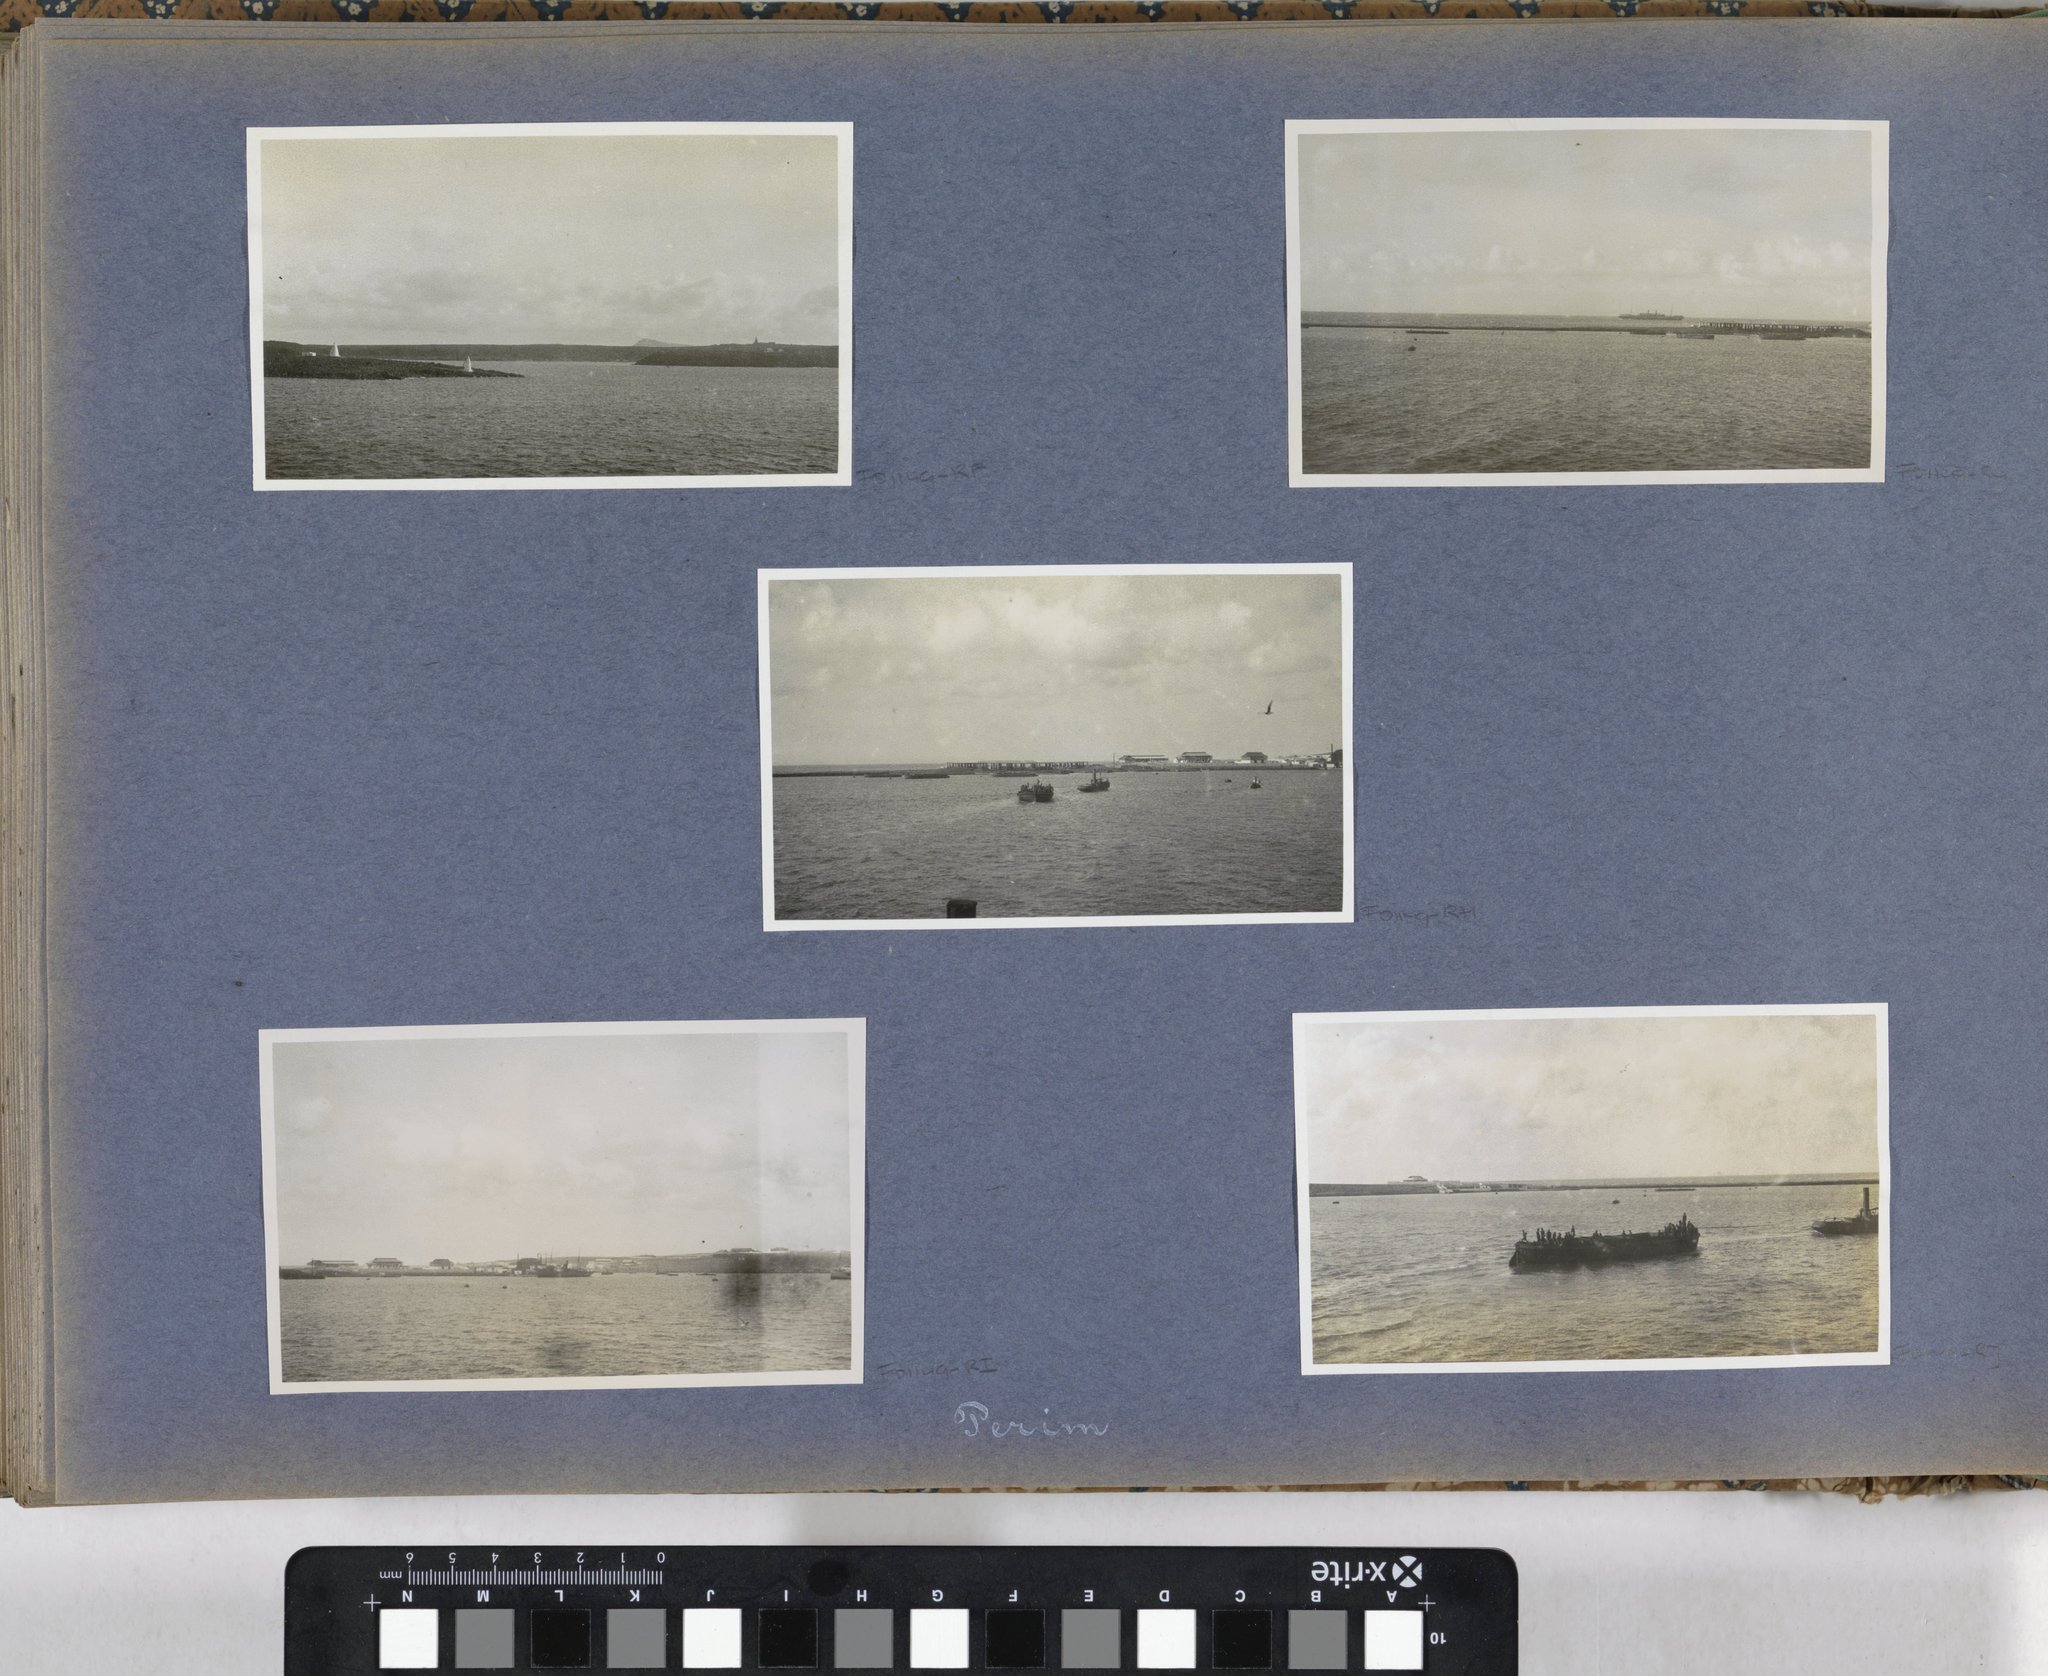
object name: photograph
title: Schepen in de haven van Perim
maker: Anonymous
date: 1900-1920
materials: paper, photographic support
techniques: gelatin silver print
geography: perim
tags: harbour, tug, pusher tug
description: Onderdeel van reisalbum met foto's van bedrijvigheid en bezienswaardigheden op Sumatra en Java en van de reis naar en van Nederlands-Indië.